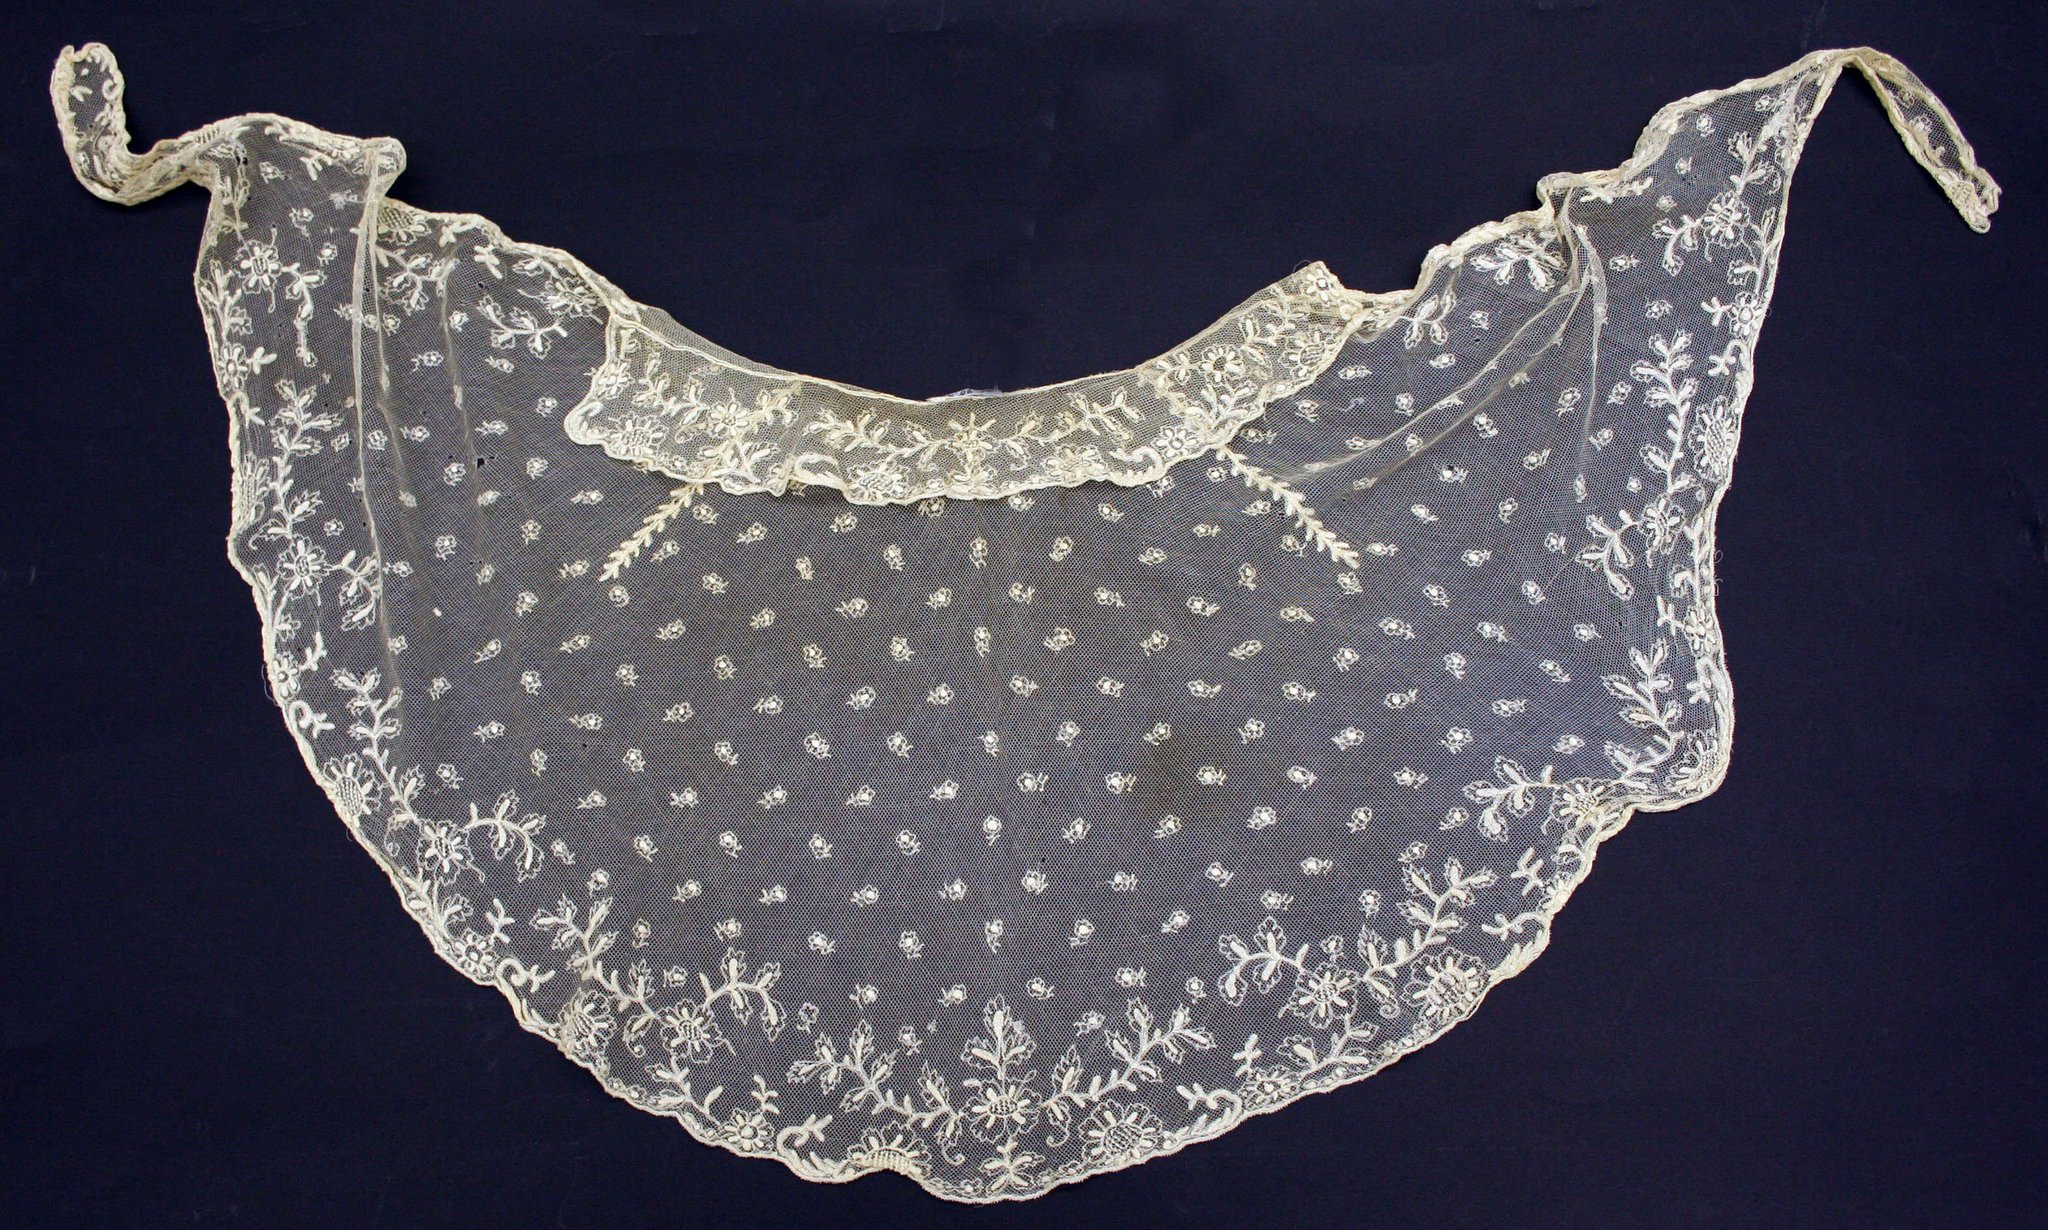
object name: fichu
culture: american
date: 1850-1859